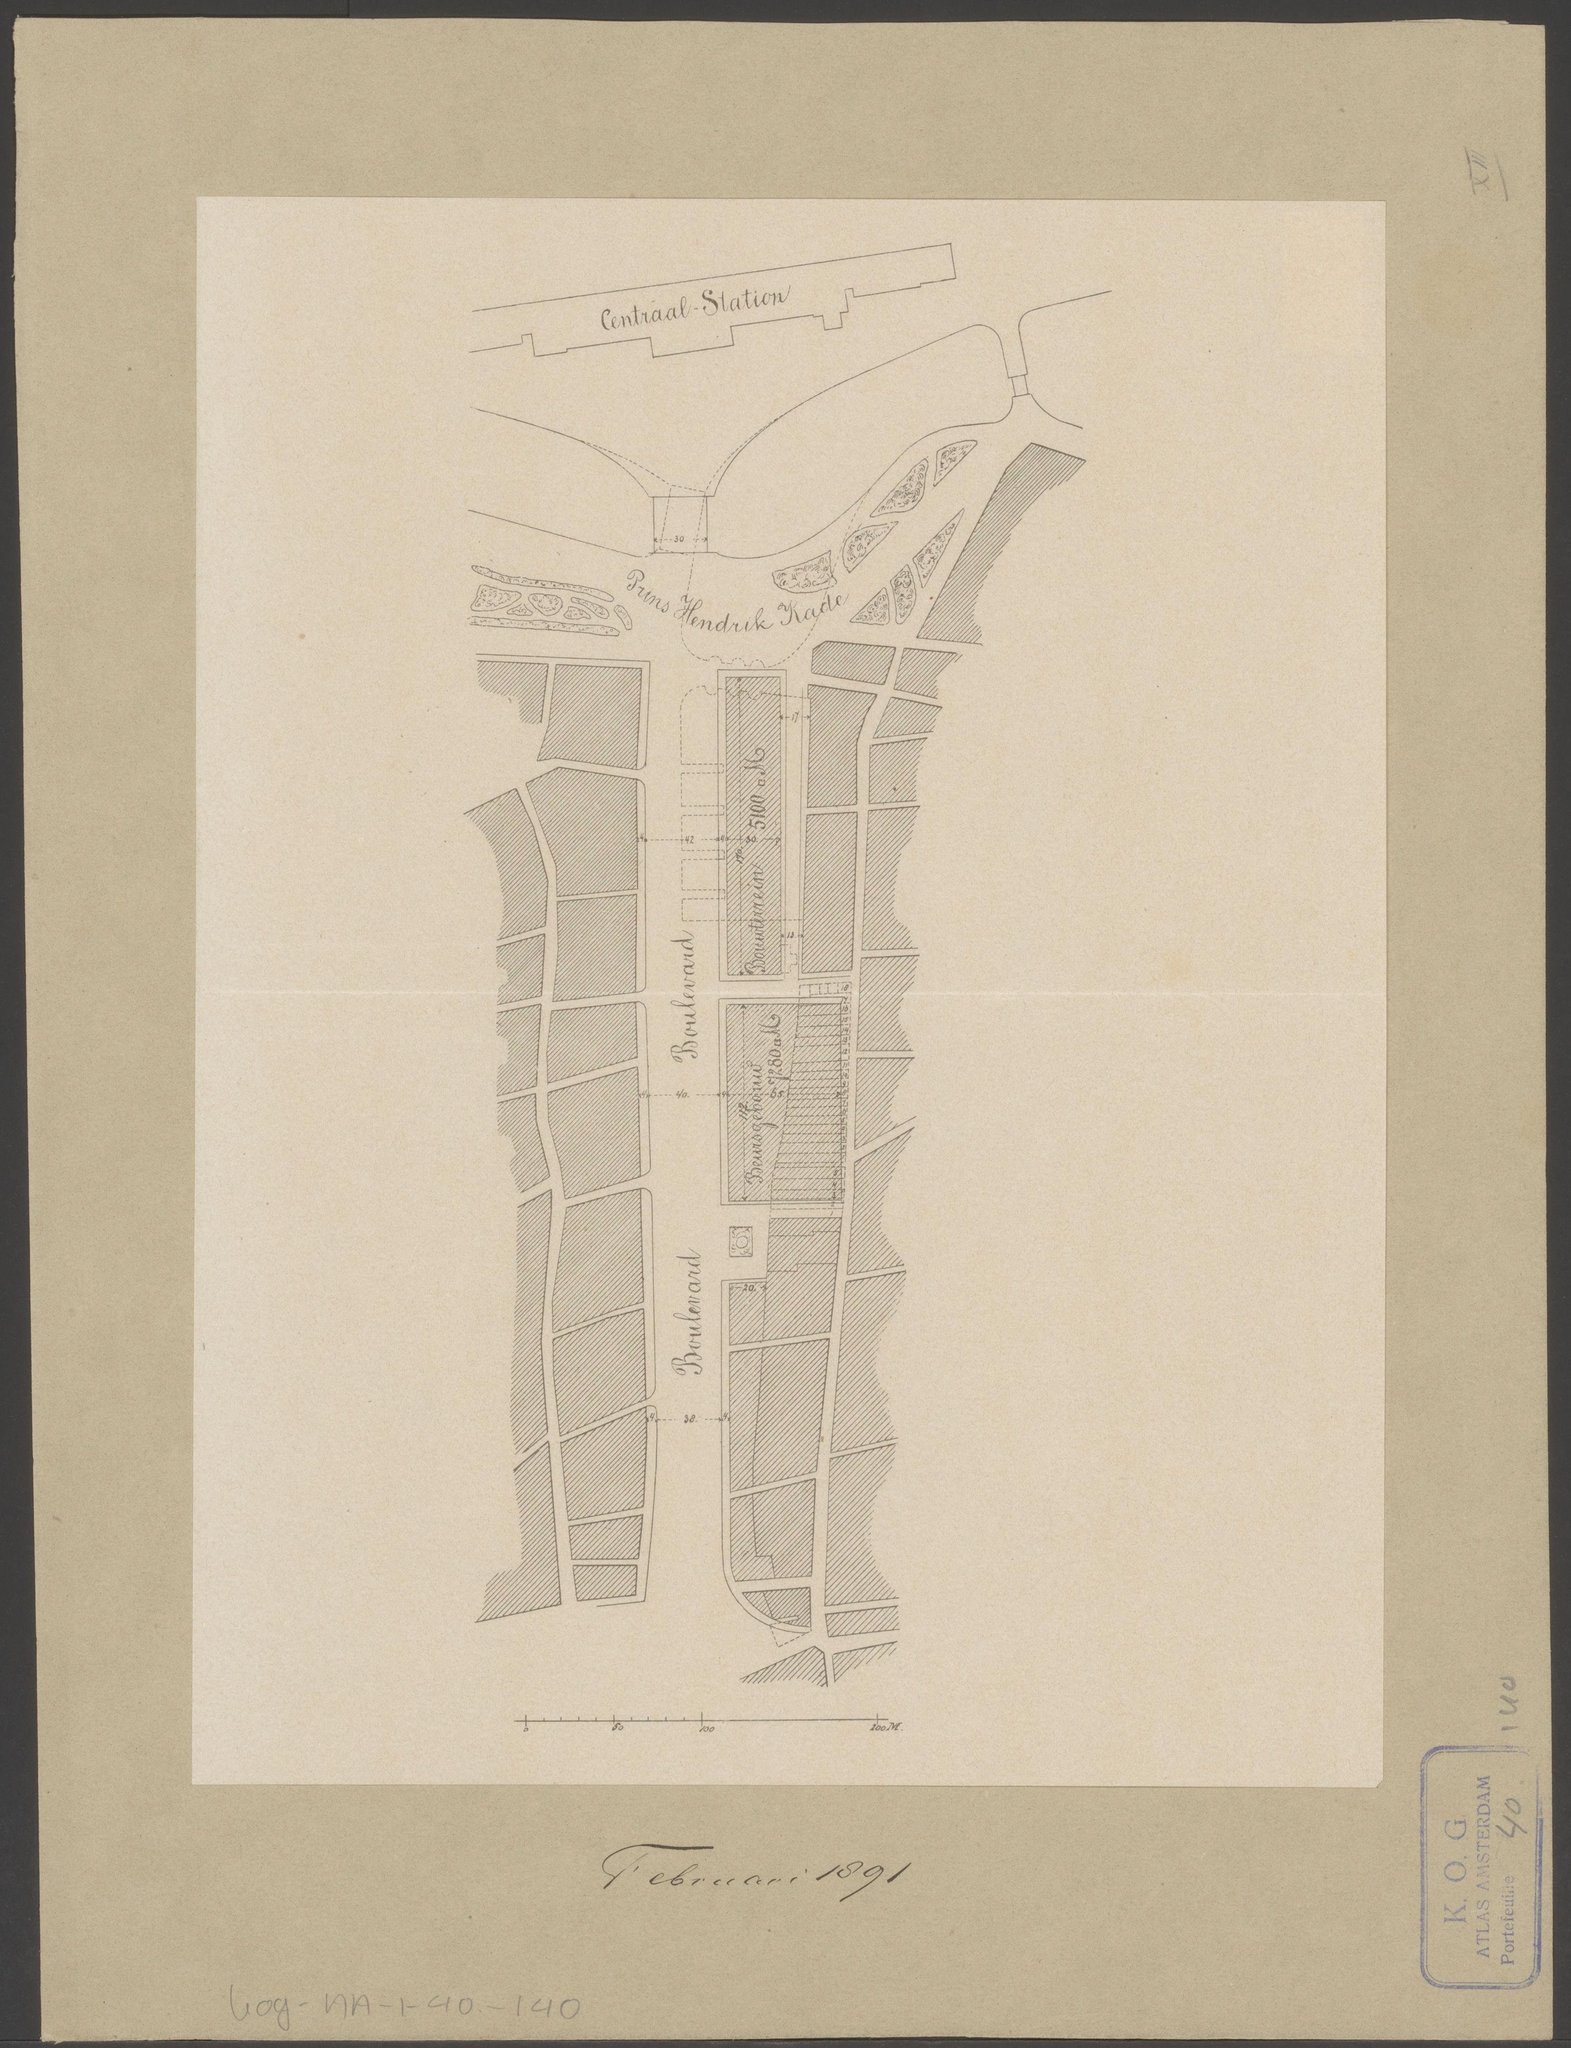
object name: print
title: Gezicht op een mogelijk beursgebouw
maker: Anonymous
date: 1884-1898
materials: paper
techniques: lithograph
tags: design, plan (~ production), stock exchange, stock-market, amsterdam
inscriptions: collector's mark: Lugt 1641b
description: Onderwerpsrubriek binnen de Atlas Amsterdam: Handel en Zeevaart, E. Spotprenten betreffende de Beurs.